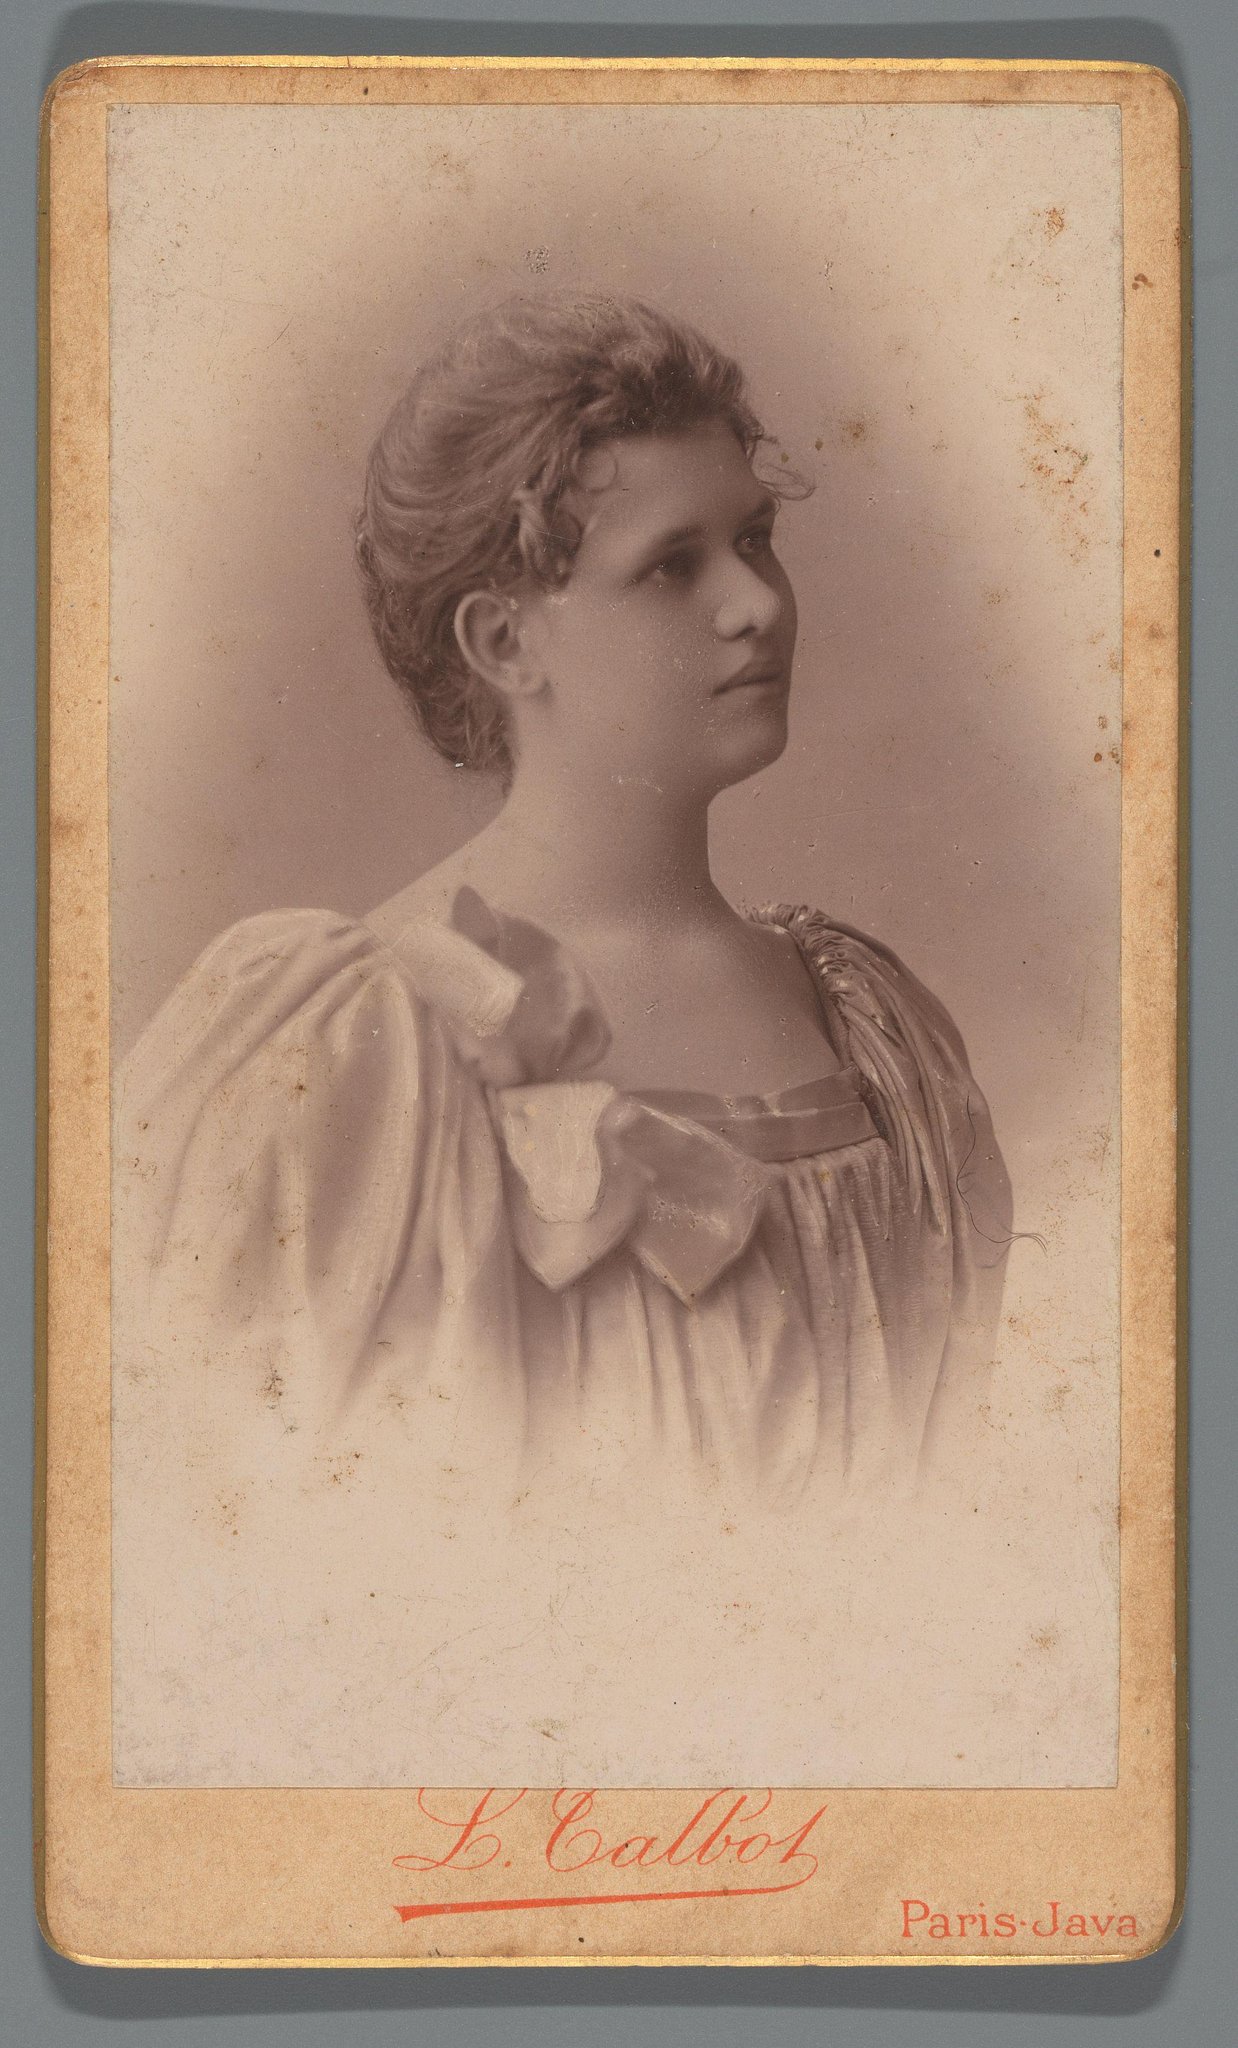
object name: carte de visite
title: Portret van tante Leo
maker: louis joseph isidore talbot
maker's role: fotograaf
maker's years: 1852-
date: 1870-1910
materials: cardboard, photographic support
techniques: albumen print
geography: batavia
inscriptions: name: ‘L. Talbot / Paris.Java’, name: ‘L. Talbot / Paris-Java’, name: ‘Tante Leo’